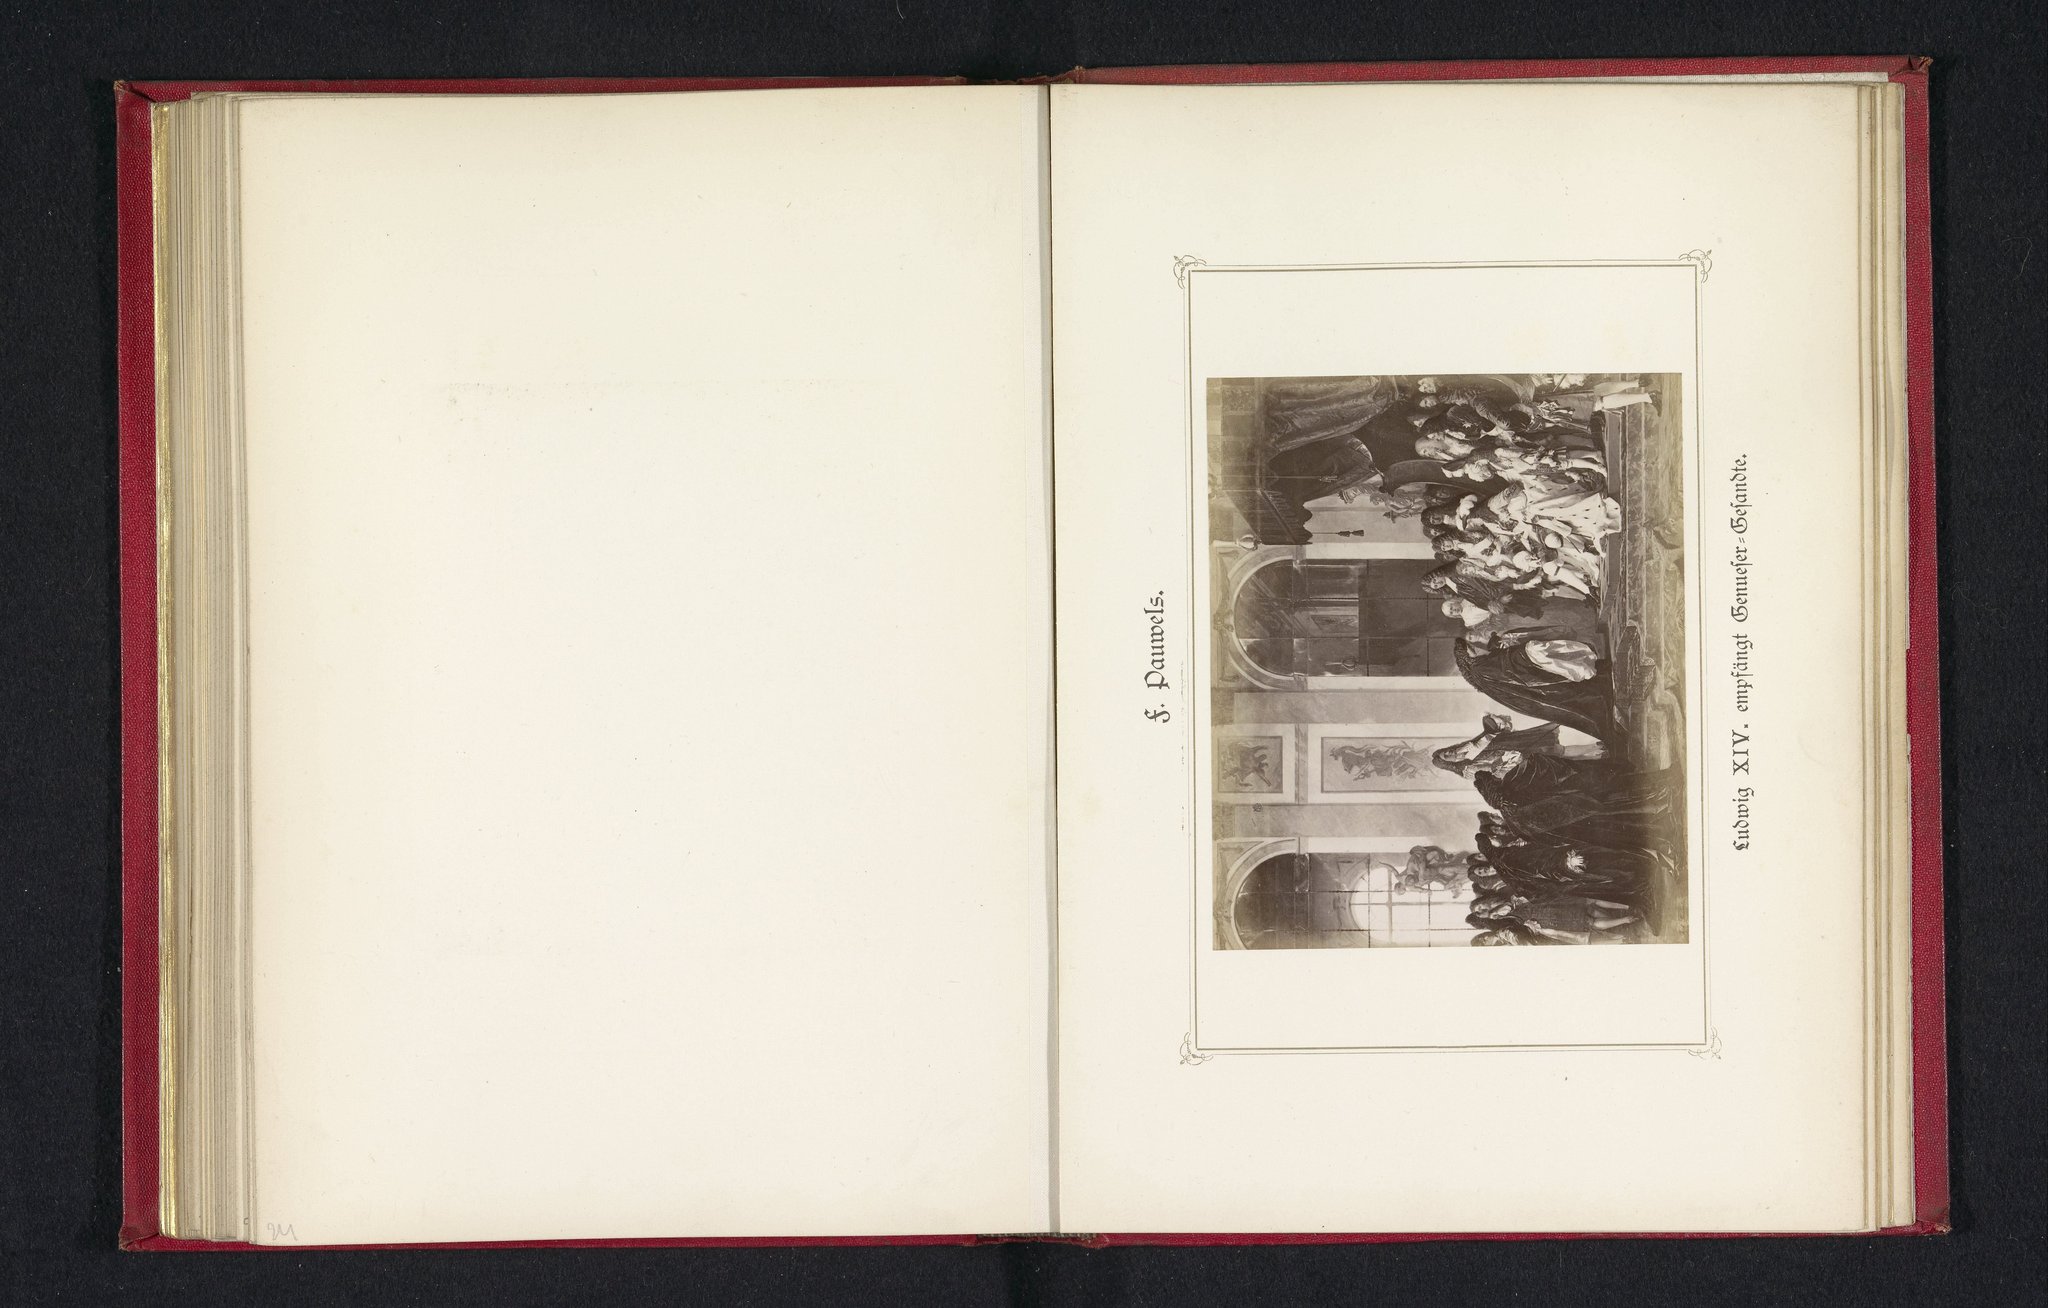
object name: reproduction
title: Königin Elisabeth von England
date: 1875-1880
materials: photographic support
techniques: albumen print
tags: review, inspection (of company, unit, troop), queen